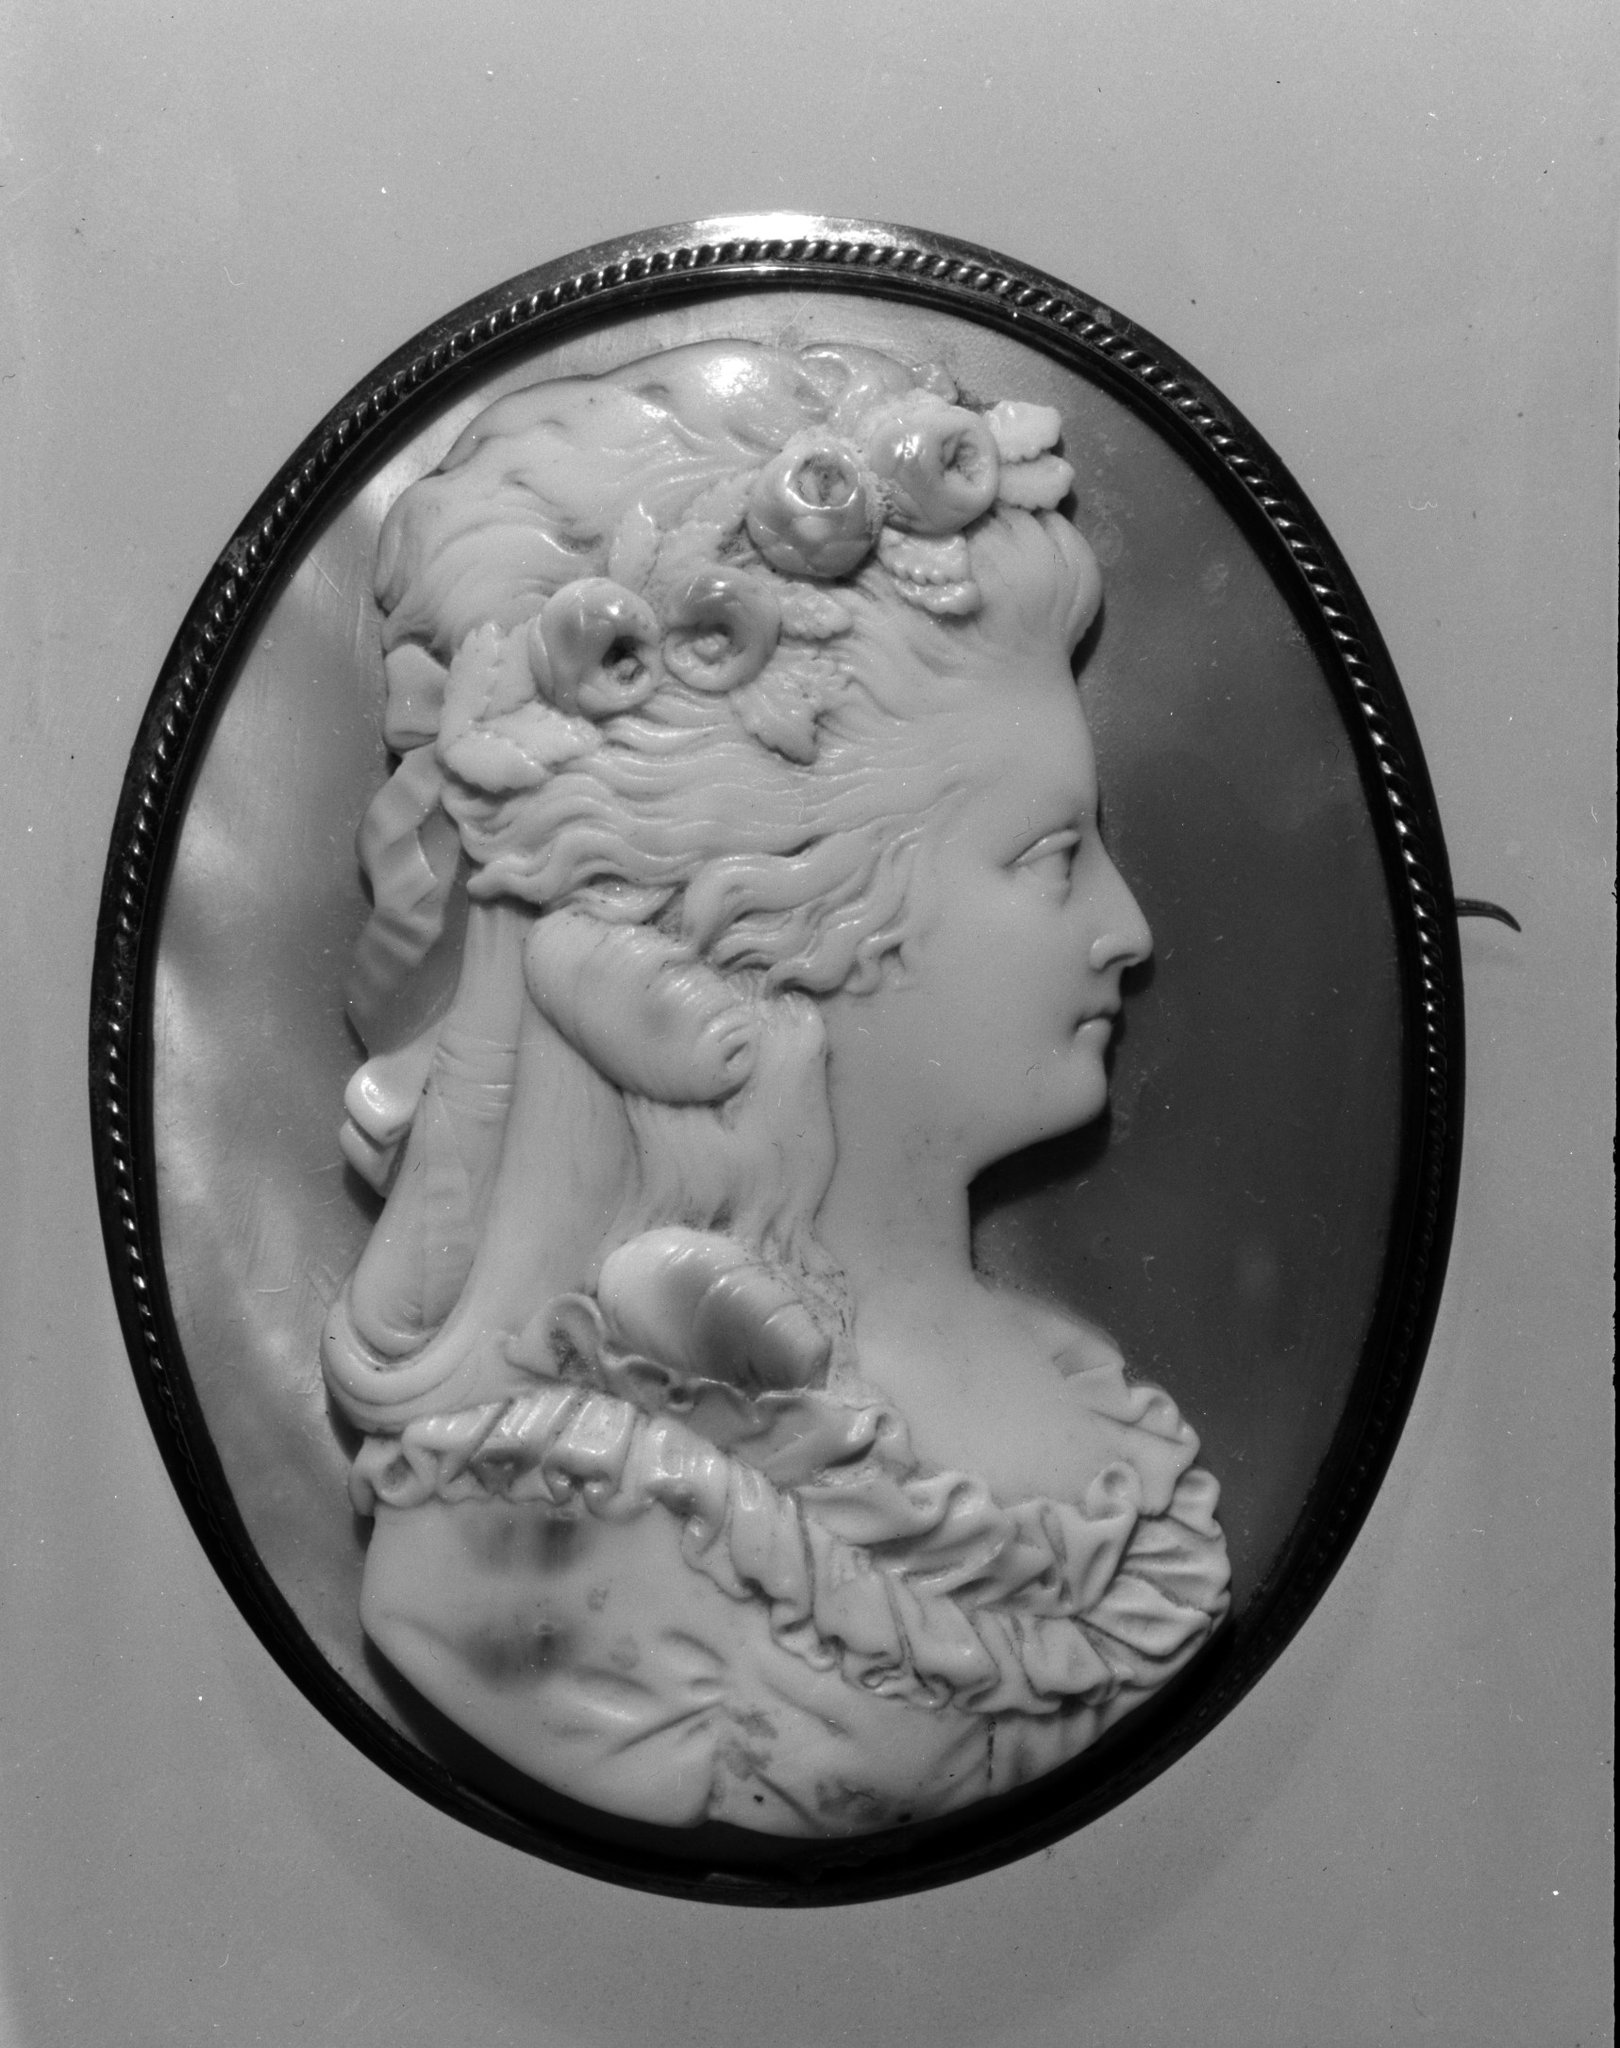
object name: brooch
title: Cameo Portrait of Martha Washington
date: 1830-1870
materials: gold, ivory, mother of pearl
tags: profiles,women